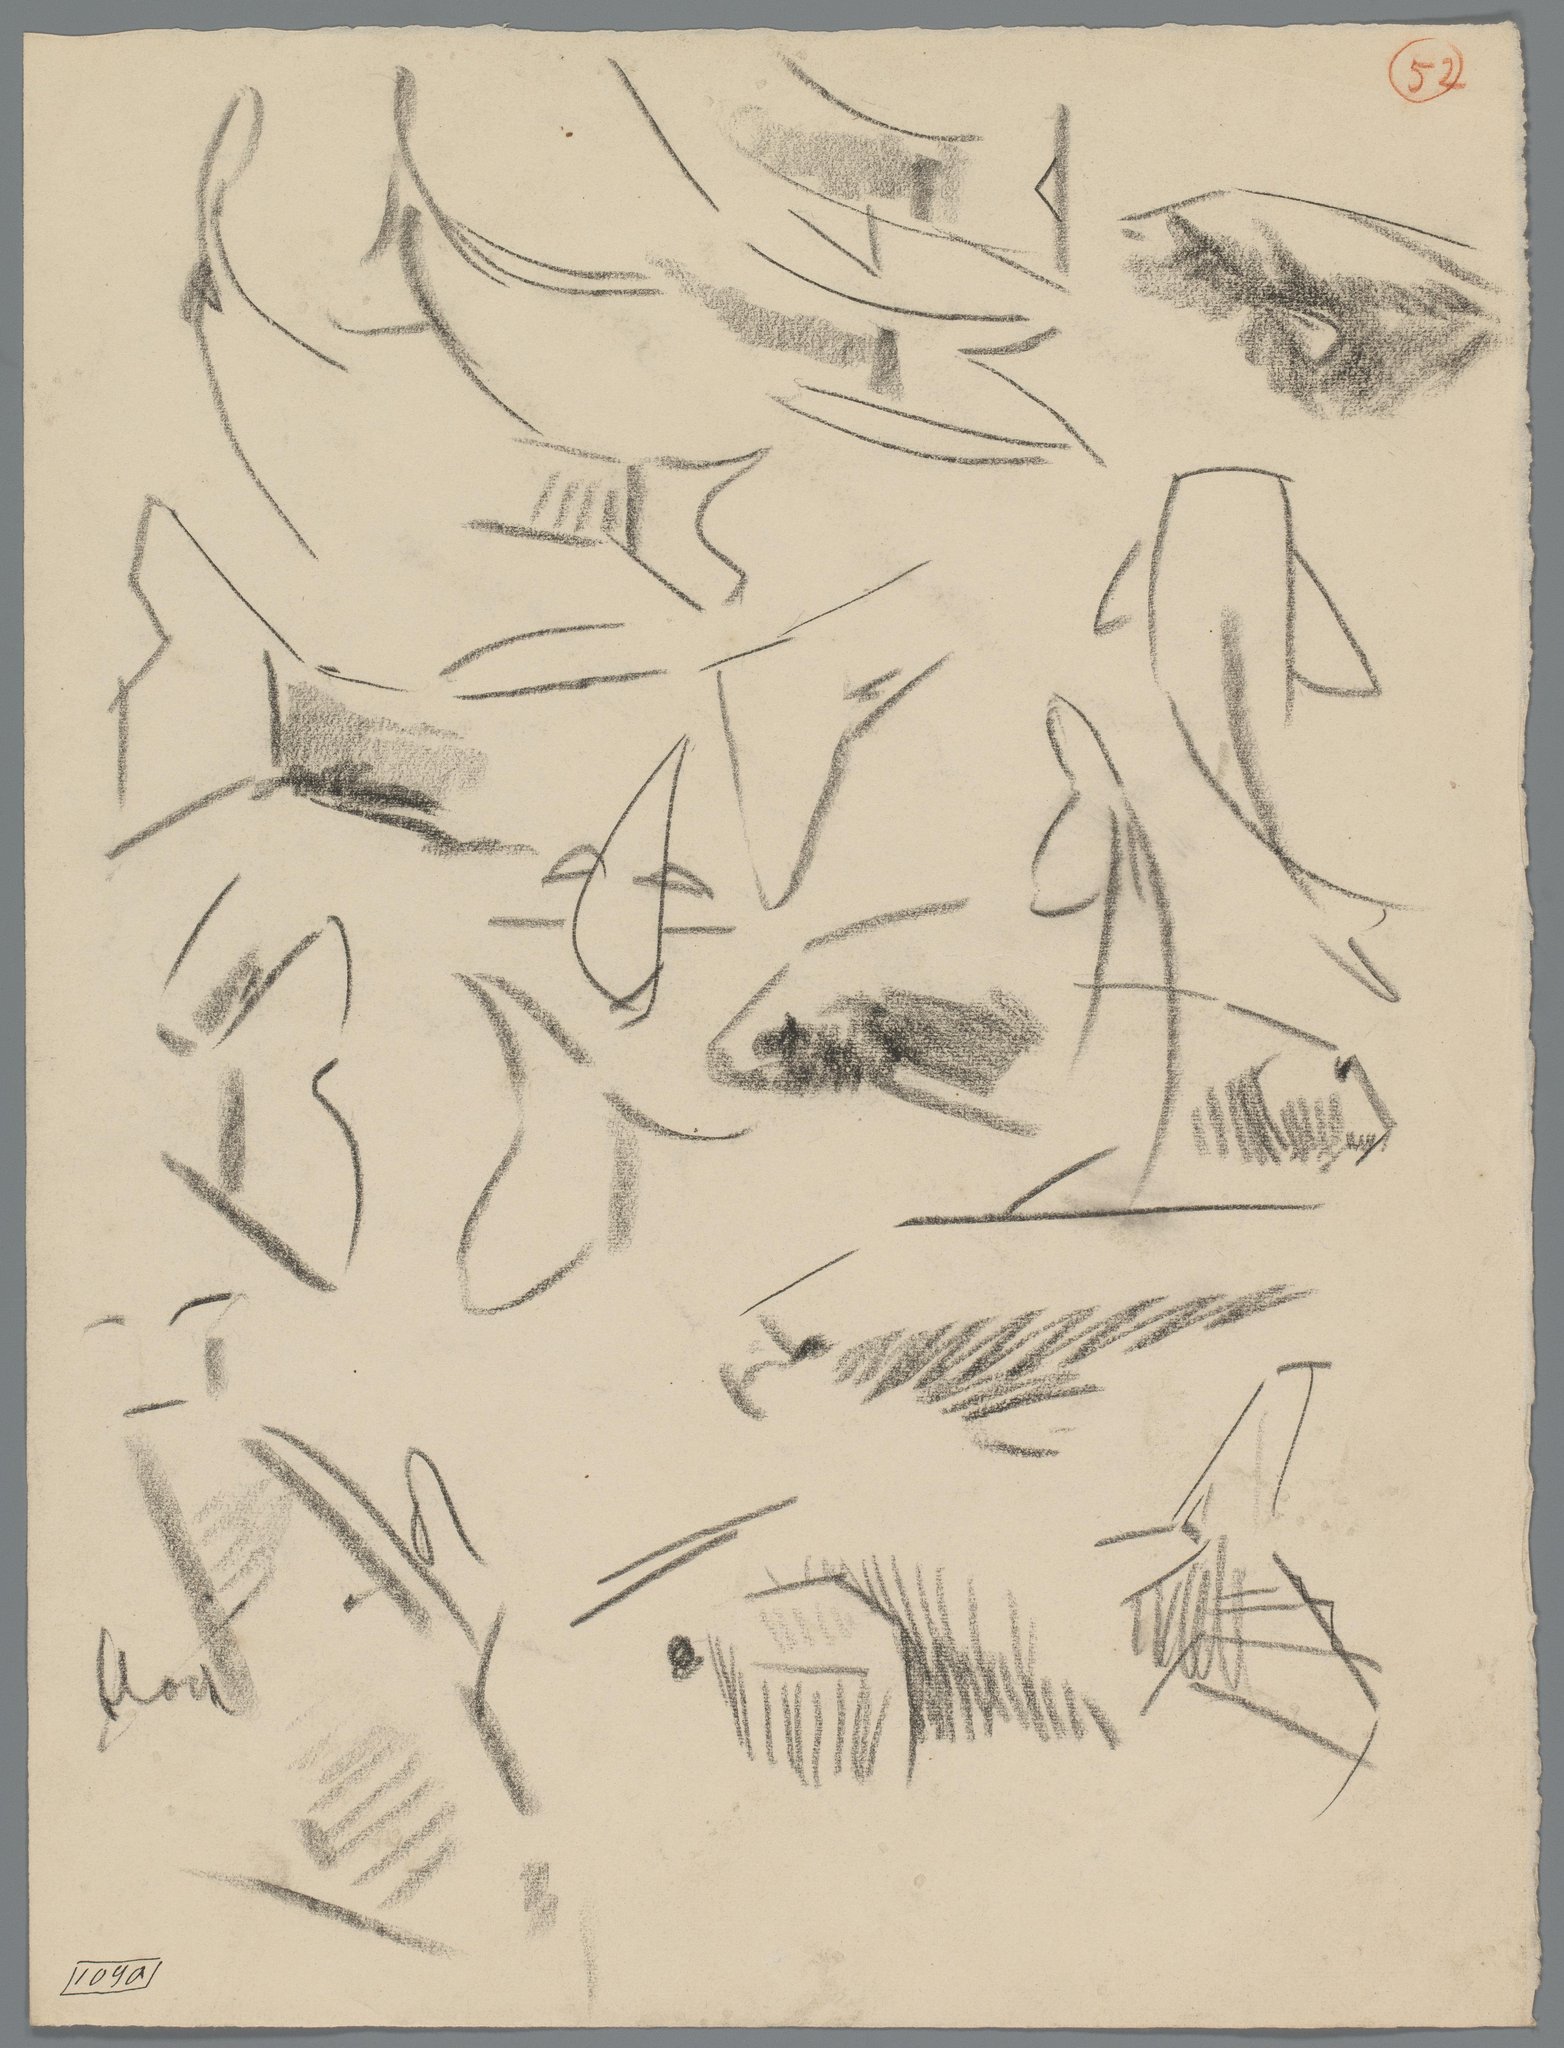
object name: drawing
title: Studieblad met staarten van karpers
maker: gerrit willem dijsselhof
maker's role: designer, draughtsman, print maker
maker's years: 1866-1924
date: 1876-1924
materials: chalk, paper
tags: bony fishes: carp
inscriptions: number: ‘1090’